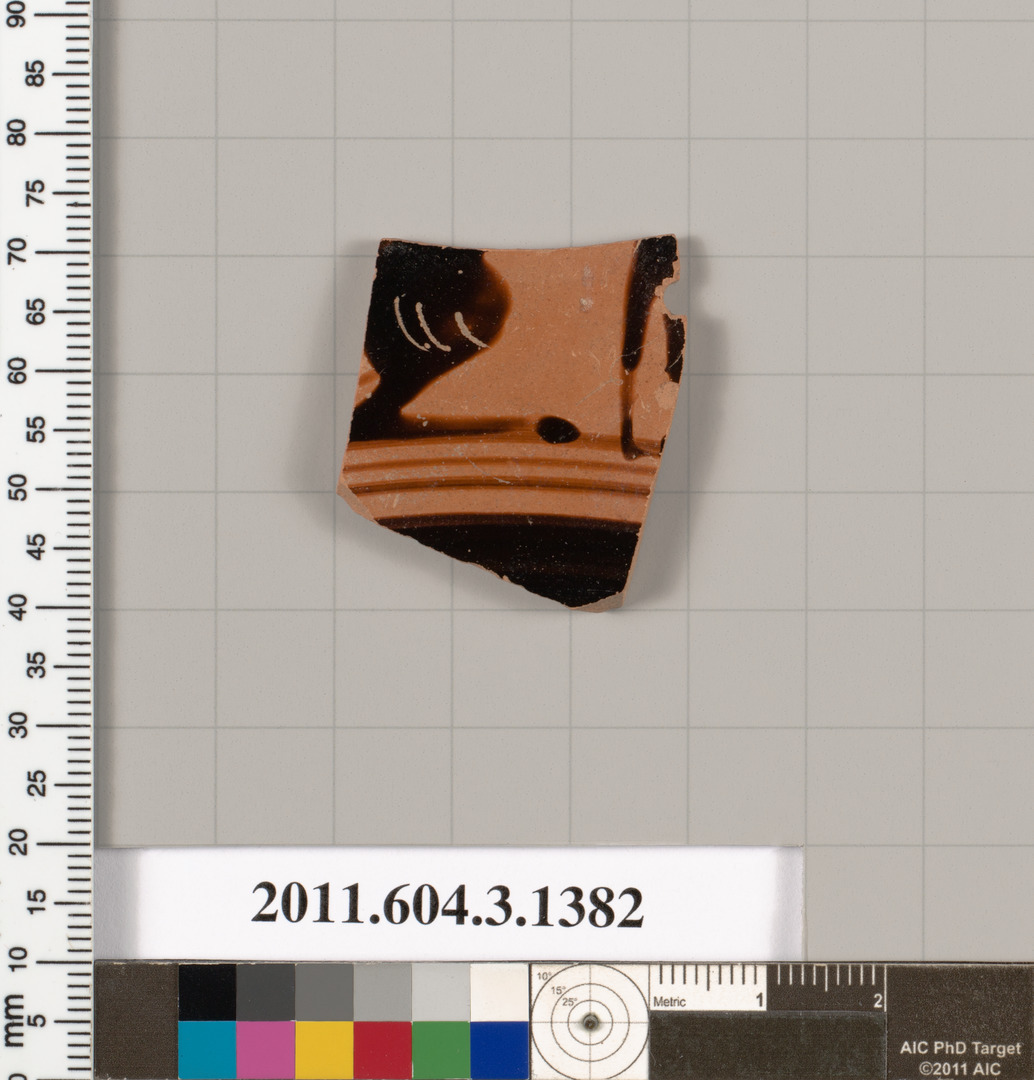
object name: skyphos fragment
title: Terracotta fragment of a skyphos (deep drinking cup)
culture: greek, attic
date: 500-468 BCE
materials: terracotta